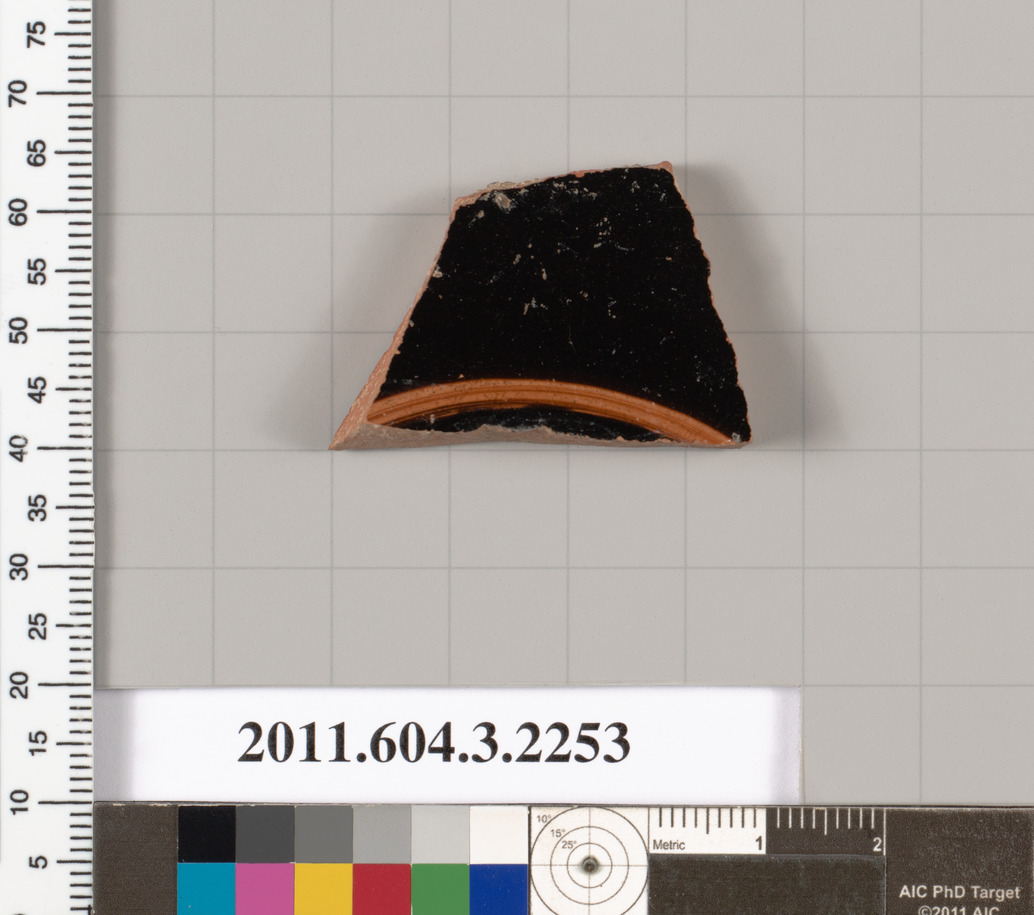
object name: kylix fragment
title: Terracotta fragment of a kylix (drinking cup)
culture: greek, attic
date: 600-401 BCE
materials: terracotta